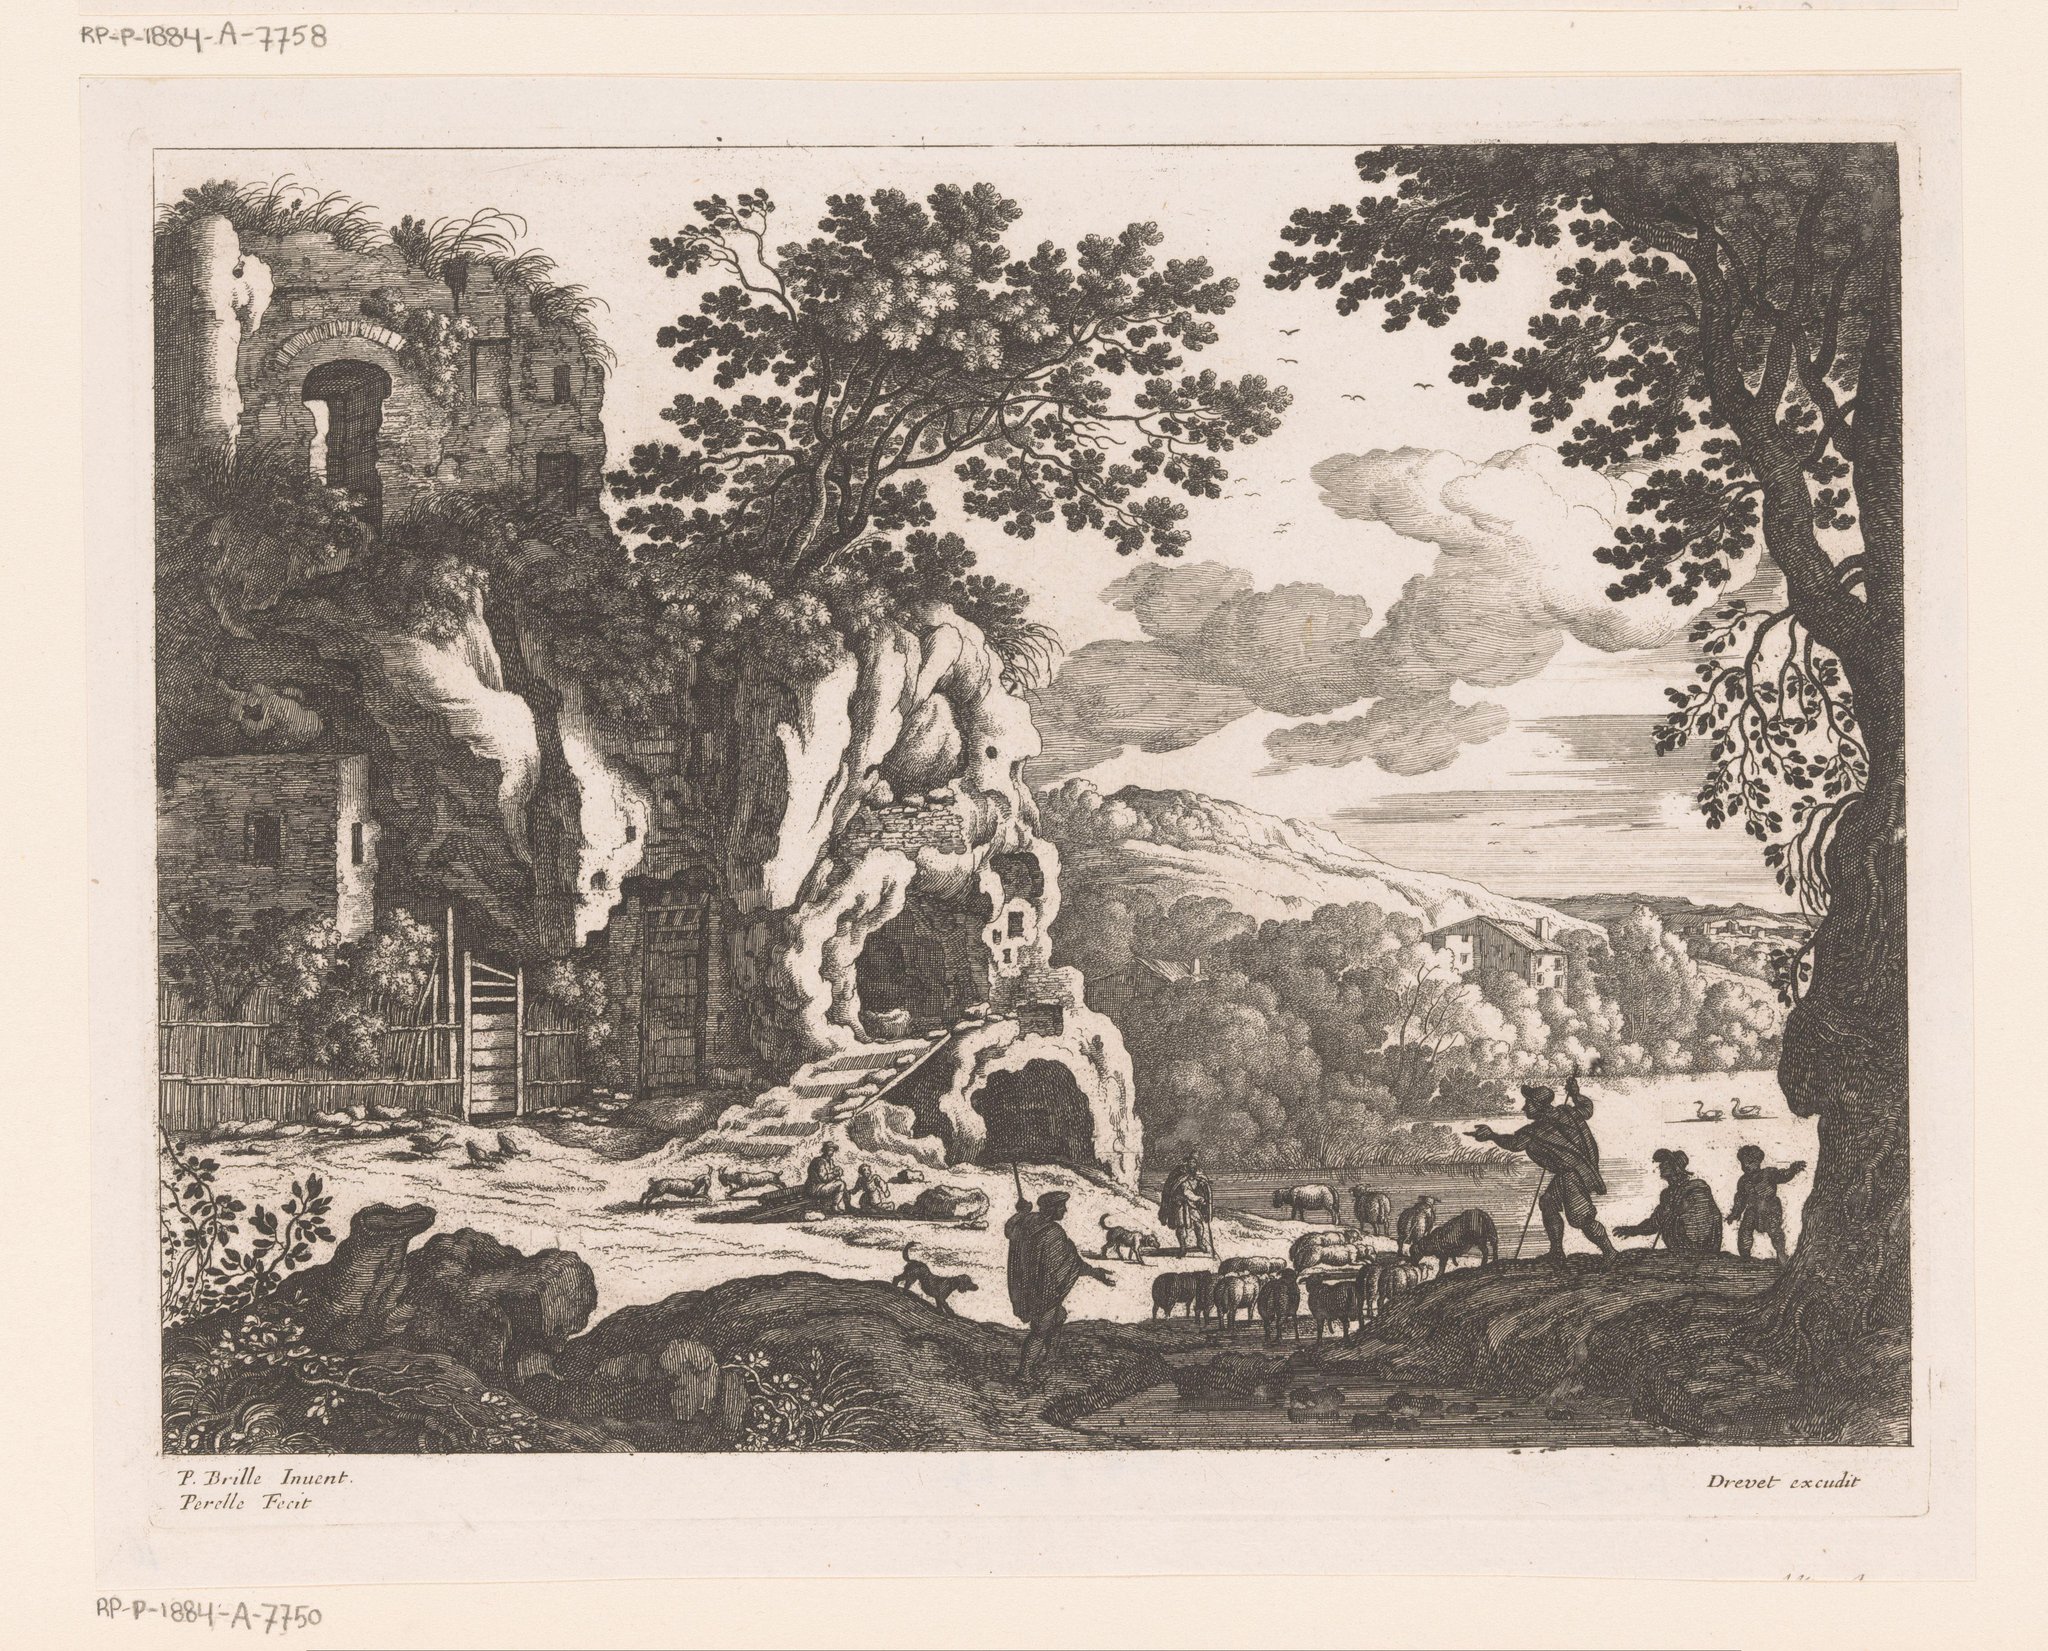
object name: print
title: Cephalus en Procris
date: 1673-1695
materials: paper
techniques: etching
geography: paris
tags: landscapes, cephalus inadvertently kills procris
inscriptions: collector's mark: Lugt 2228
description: Prenten met het signatuur 'Perelle' kunnen zowel door vader Gabriel als door zonen Nicolas en Adam gemaakt zijn.